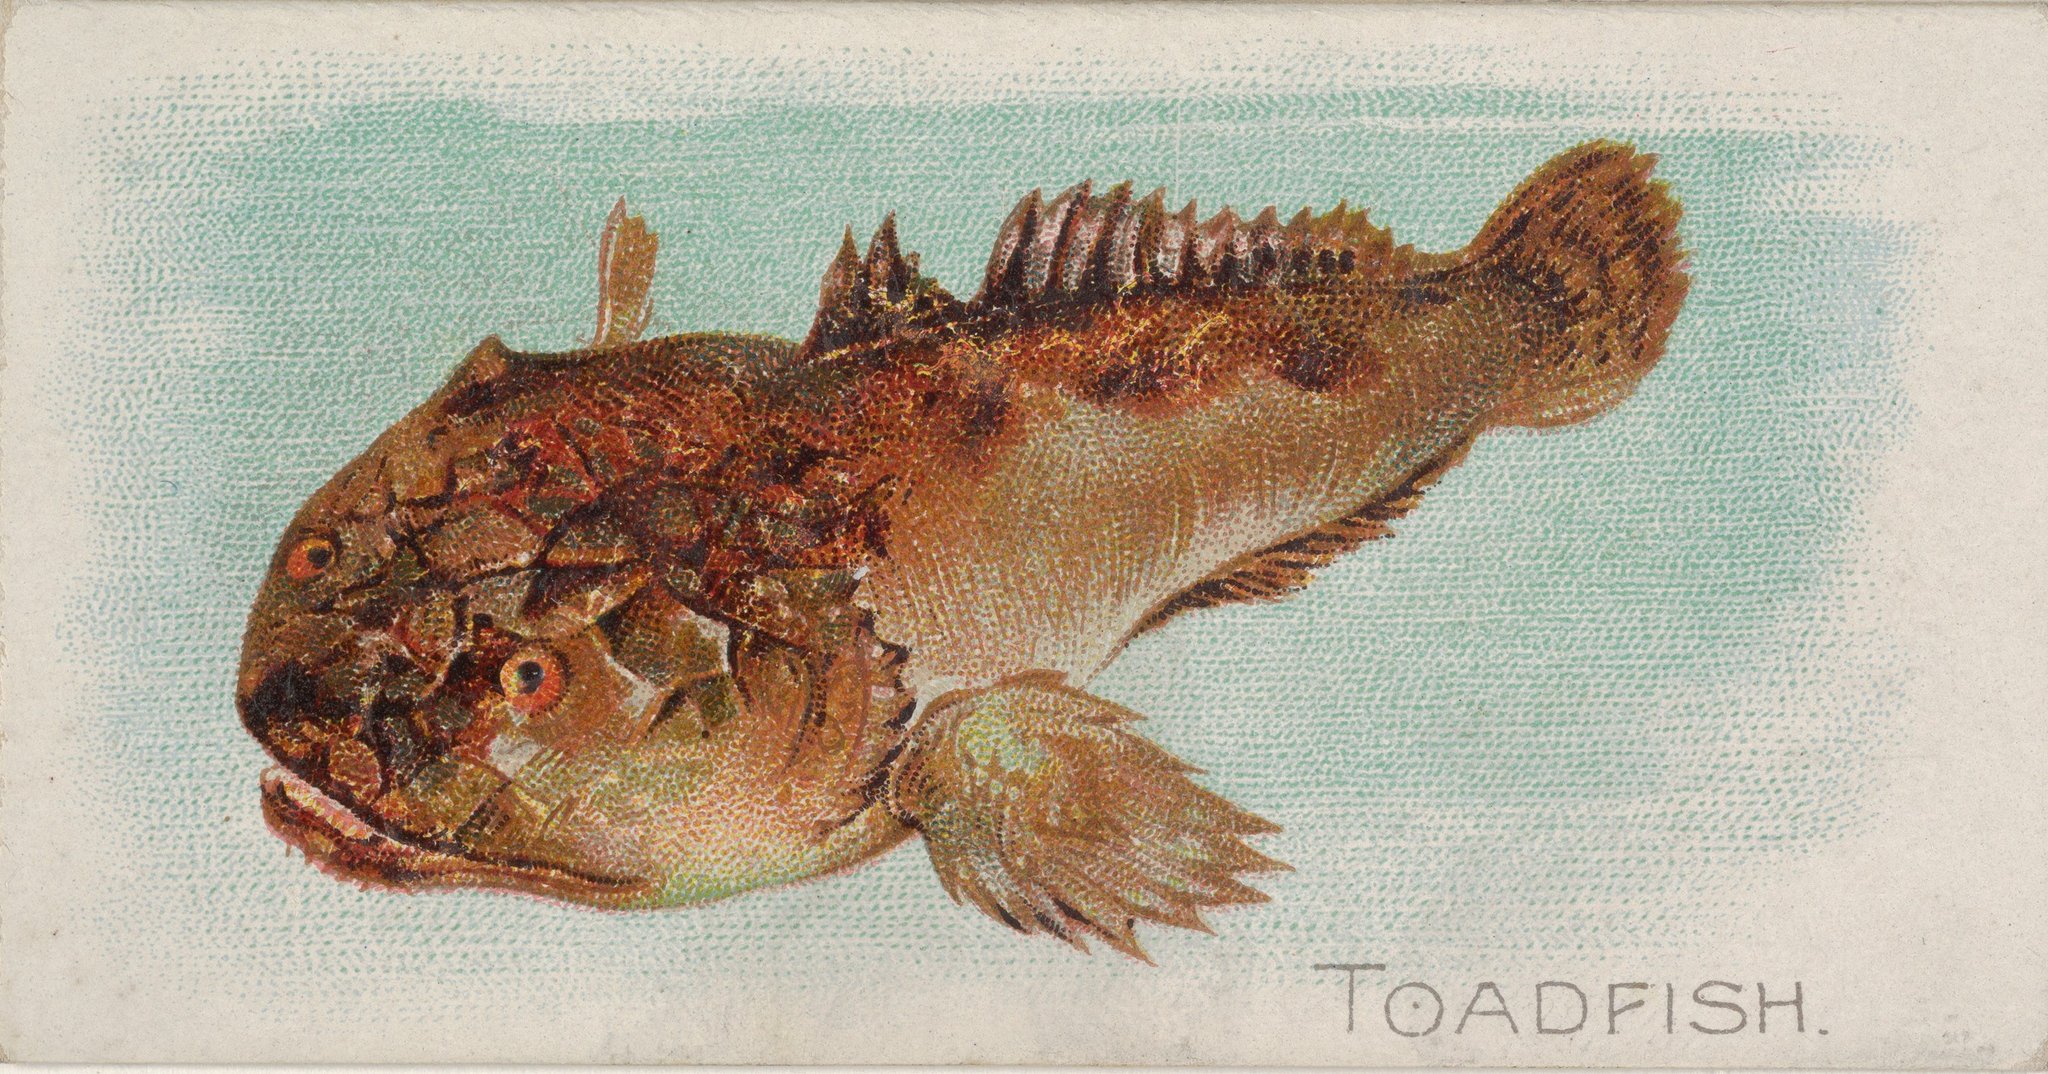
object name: print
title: Toadfish, from the Fish from American Waters series (N8) for Allen & Ginter Cigarettes Brands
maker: allen & ginter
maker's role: publisher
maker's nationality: american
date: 1889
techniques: color lithograph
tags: fish